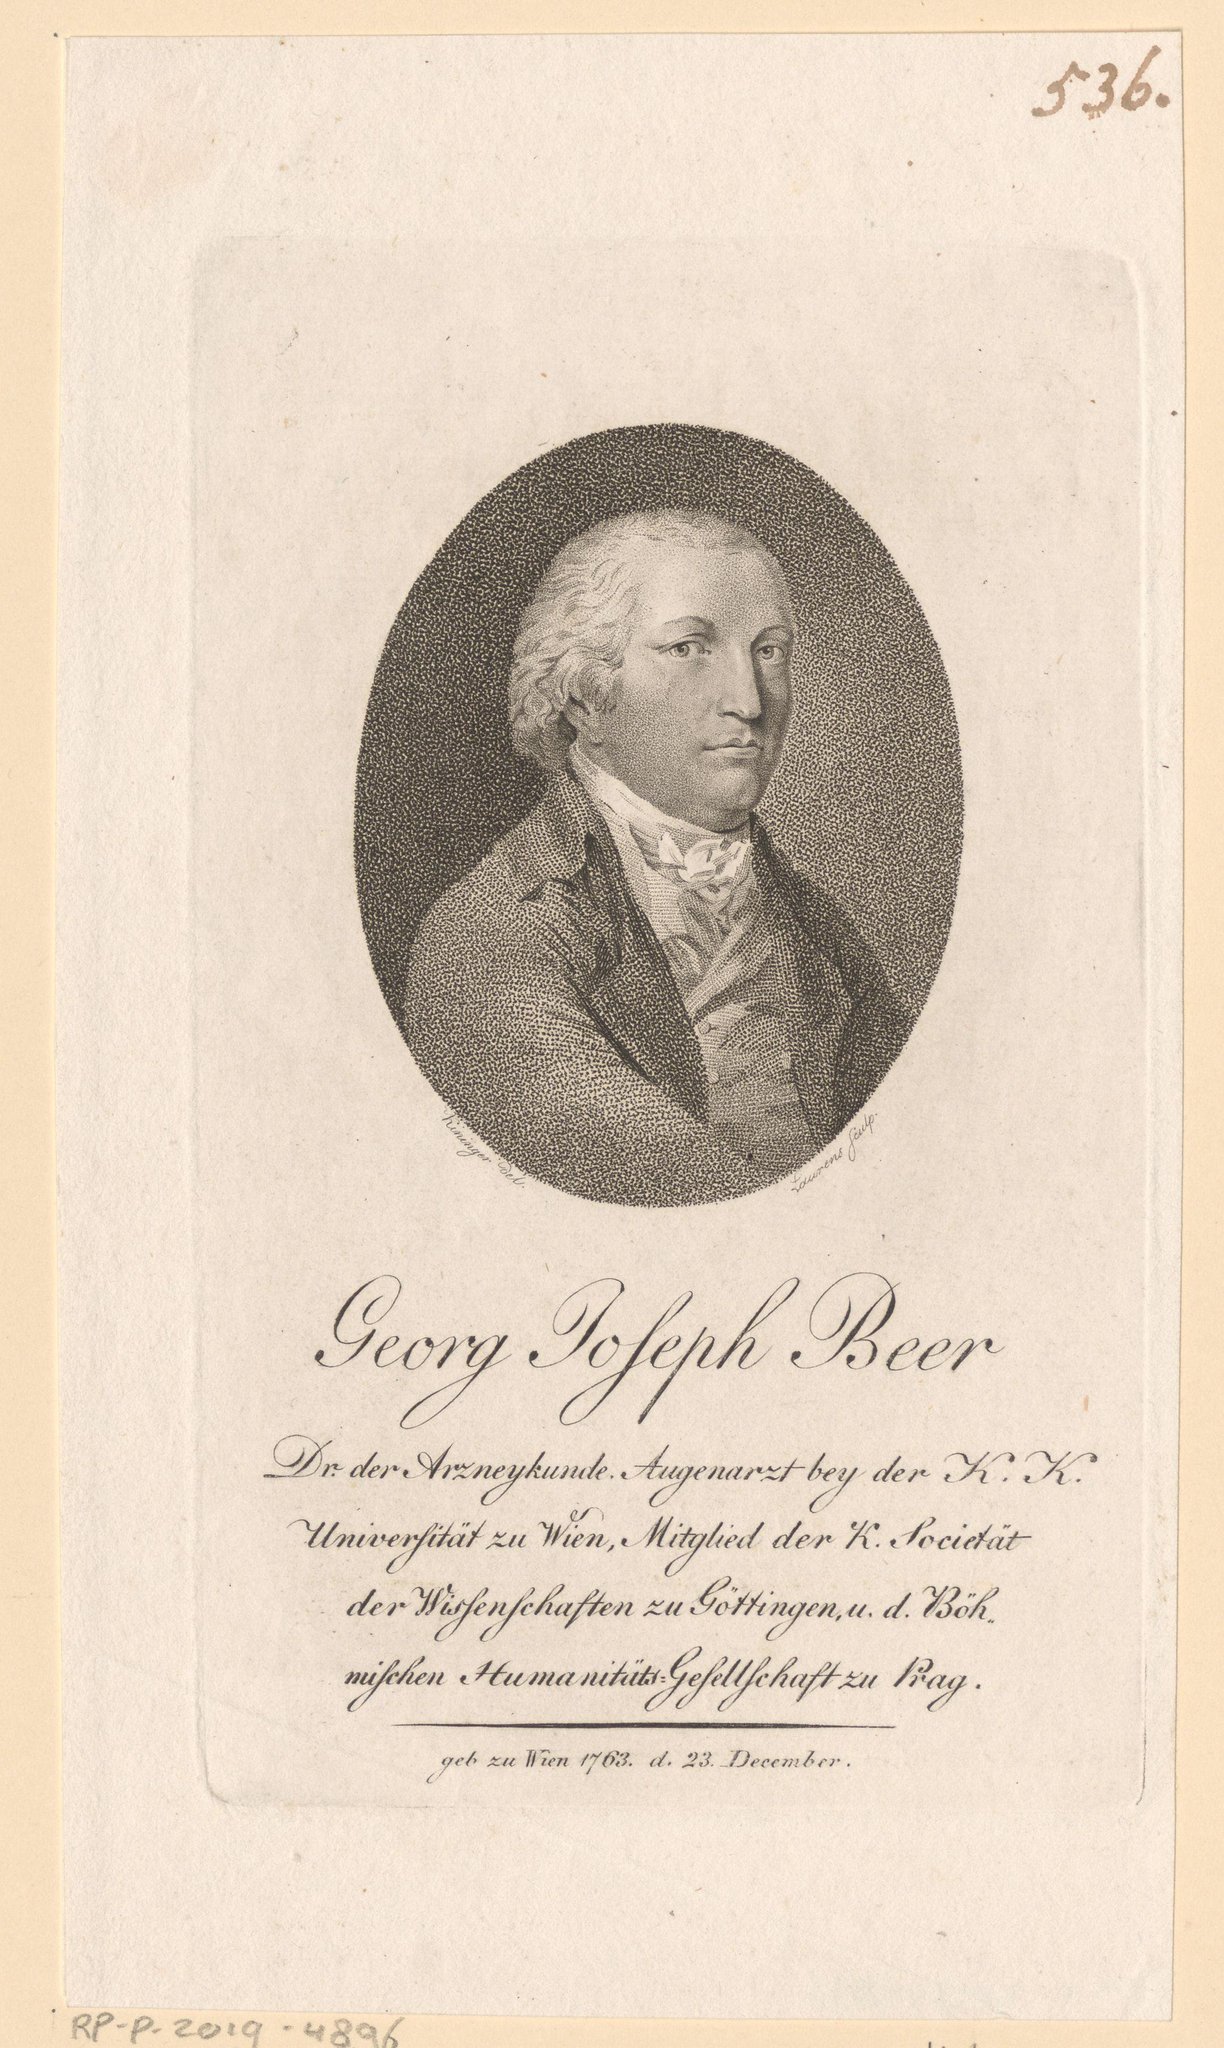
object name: print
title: Portret van Georg Joseph Beer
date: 1804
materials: paper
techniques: etching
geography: berlin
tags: historical persons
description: Prent uit: Neue allgemeine deutsche Bibliothek. Berlijn en Stettin: Friedrich Nicolai, 1804, dl. 86.